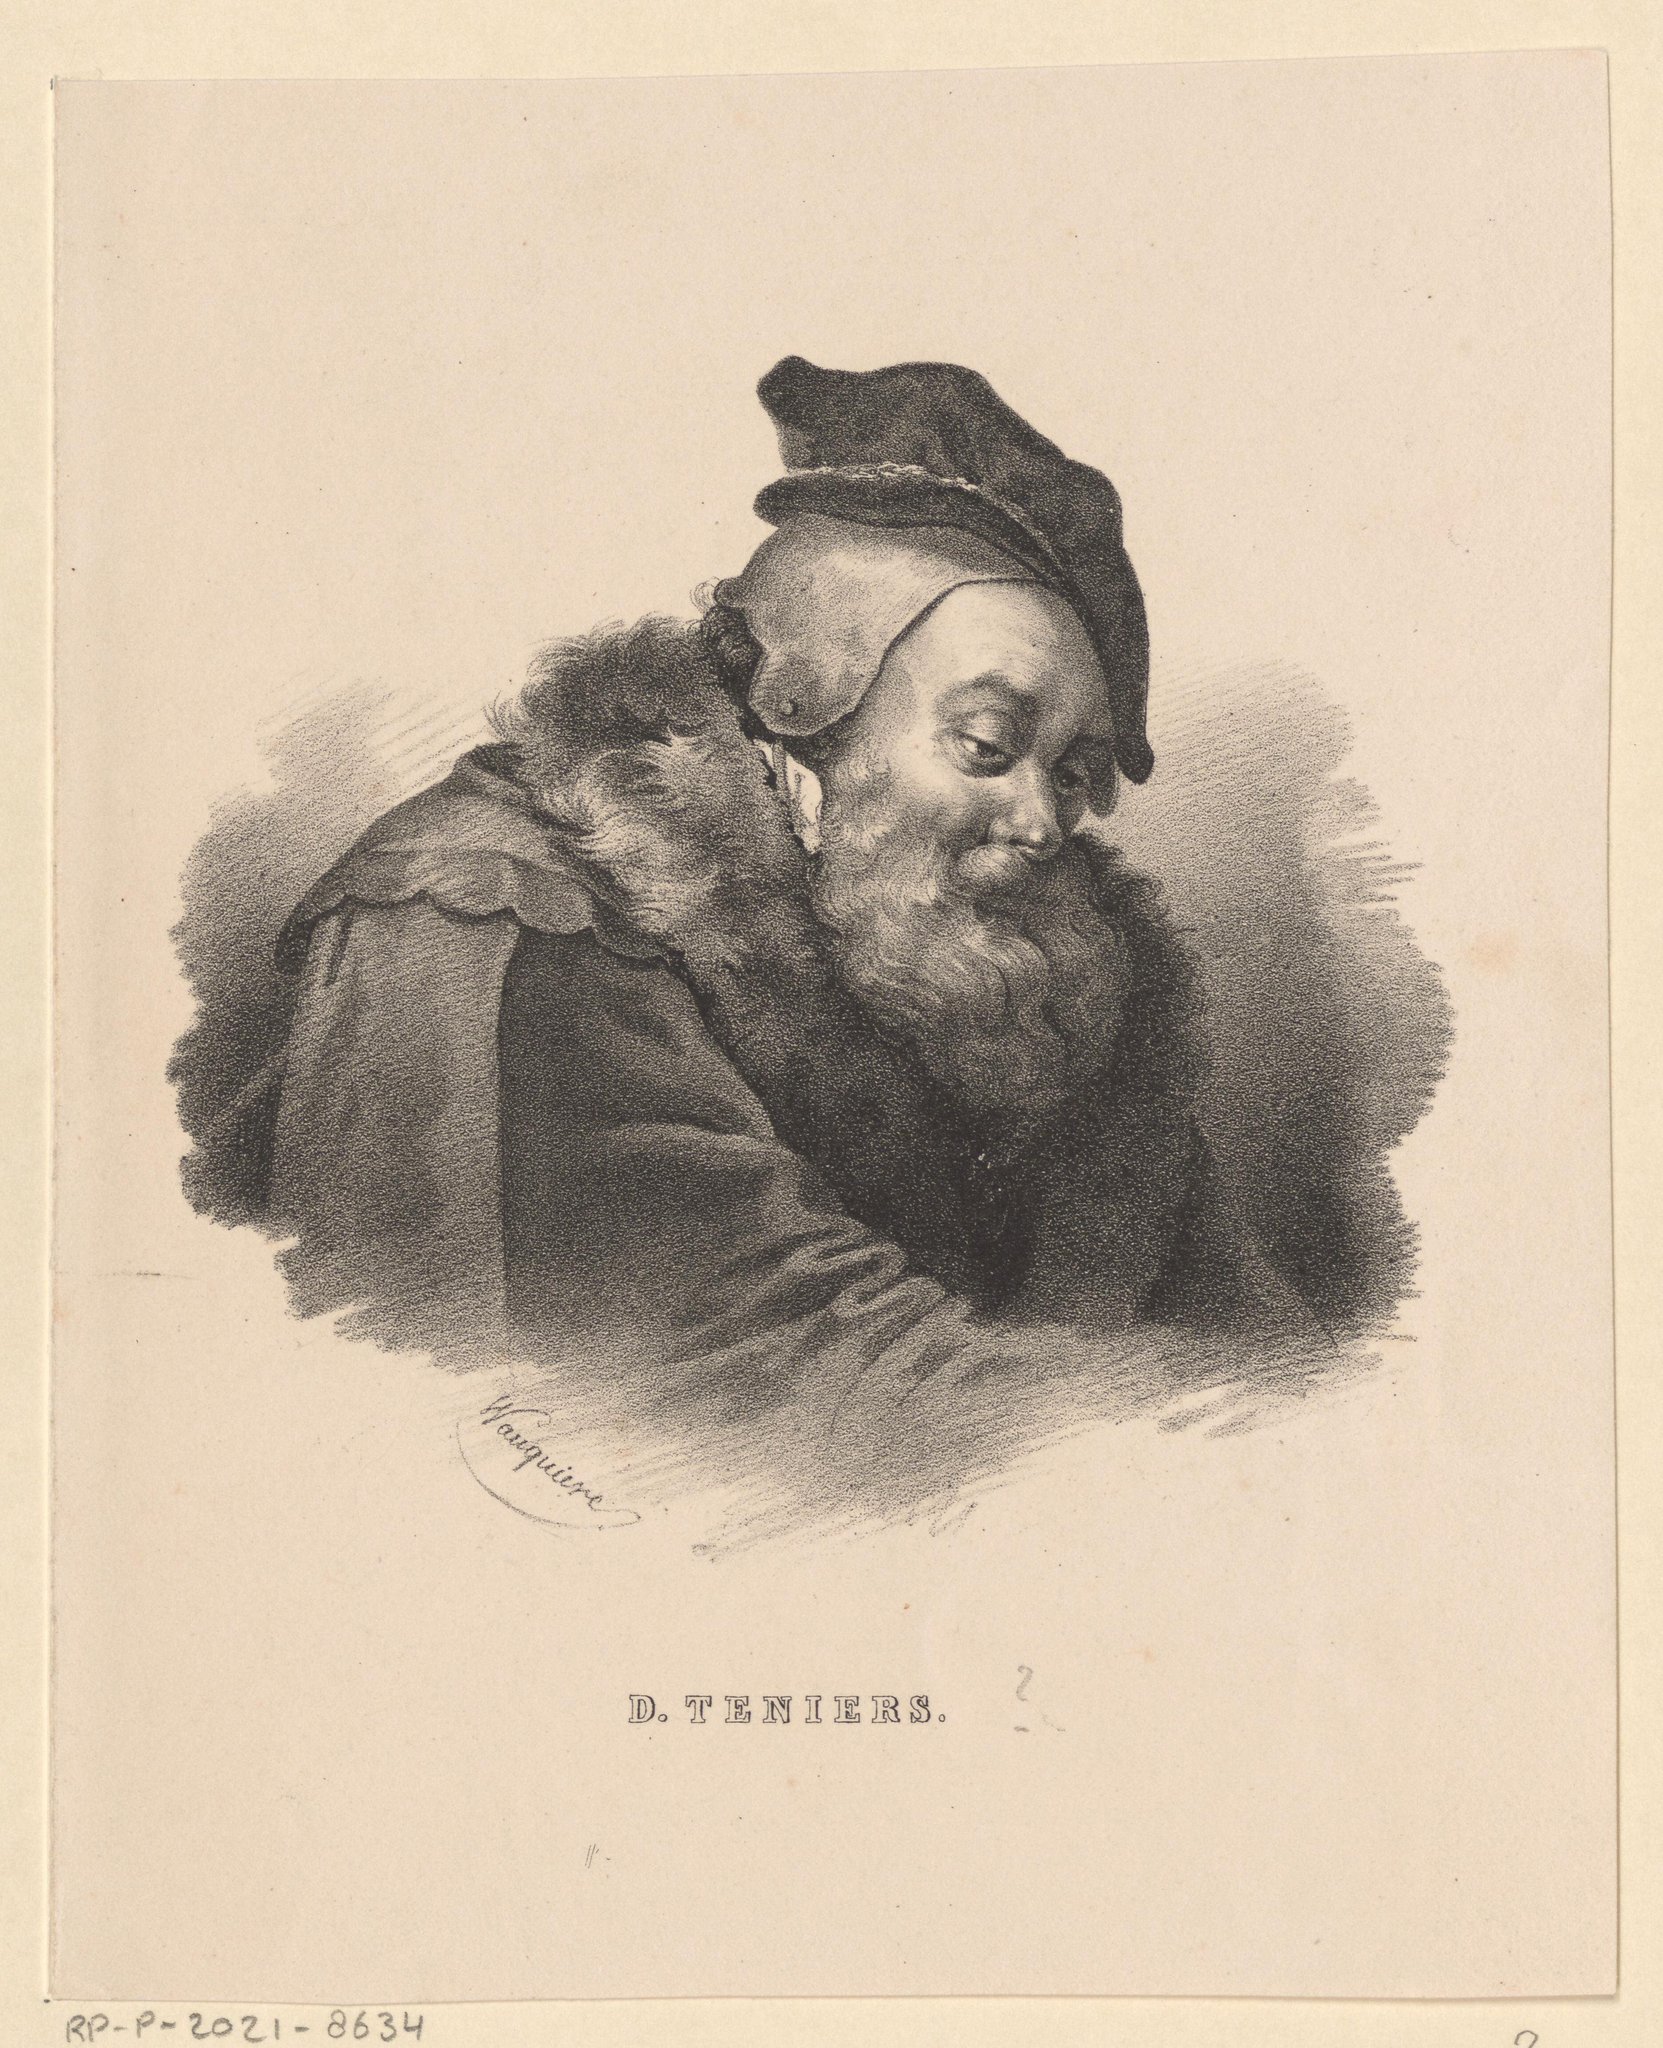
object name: print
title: Portret van David Teniers II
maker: etienne wauquier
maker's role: painter, print maker, sculptor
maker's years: 1808-1869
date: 1818-1869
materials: paper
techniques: lithograph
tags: antwerp, brussels, draughtsman, david teniers (ii), historical persons, portrait, self-portrait of painter